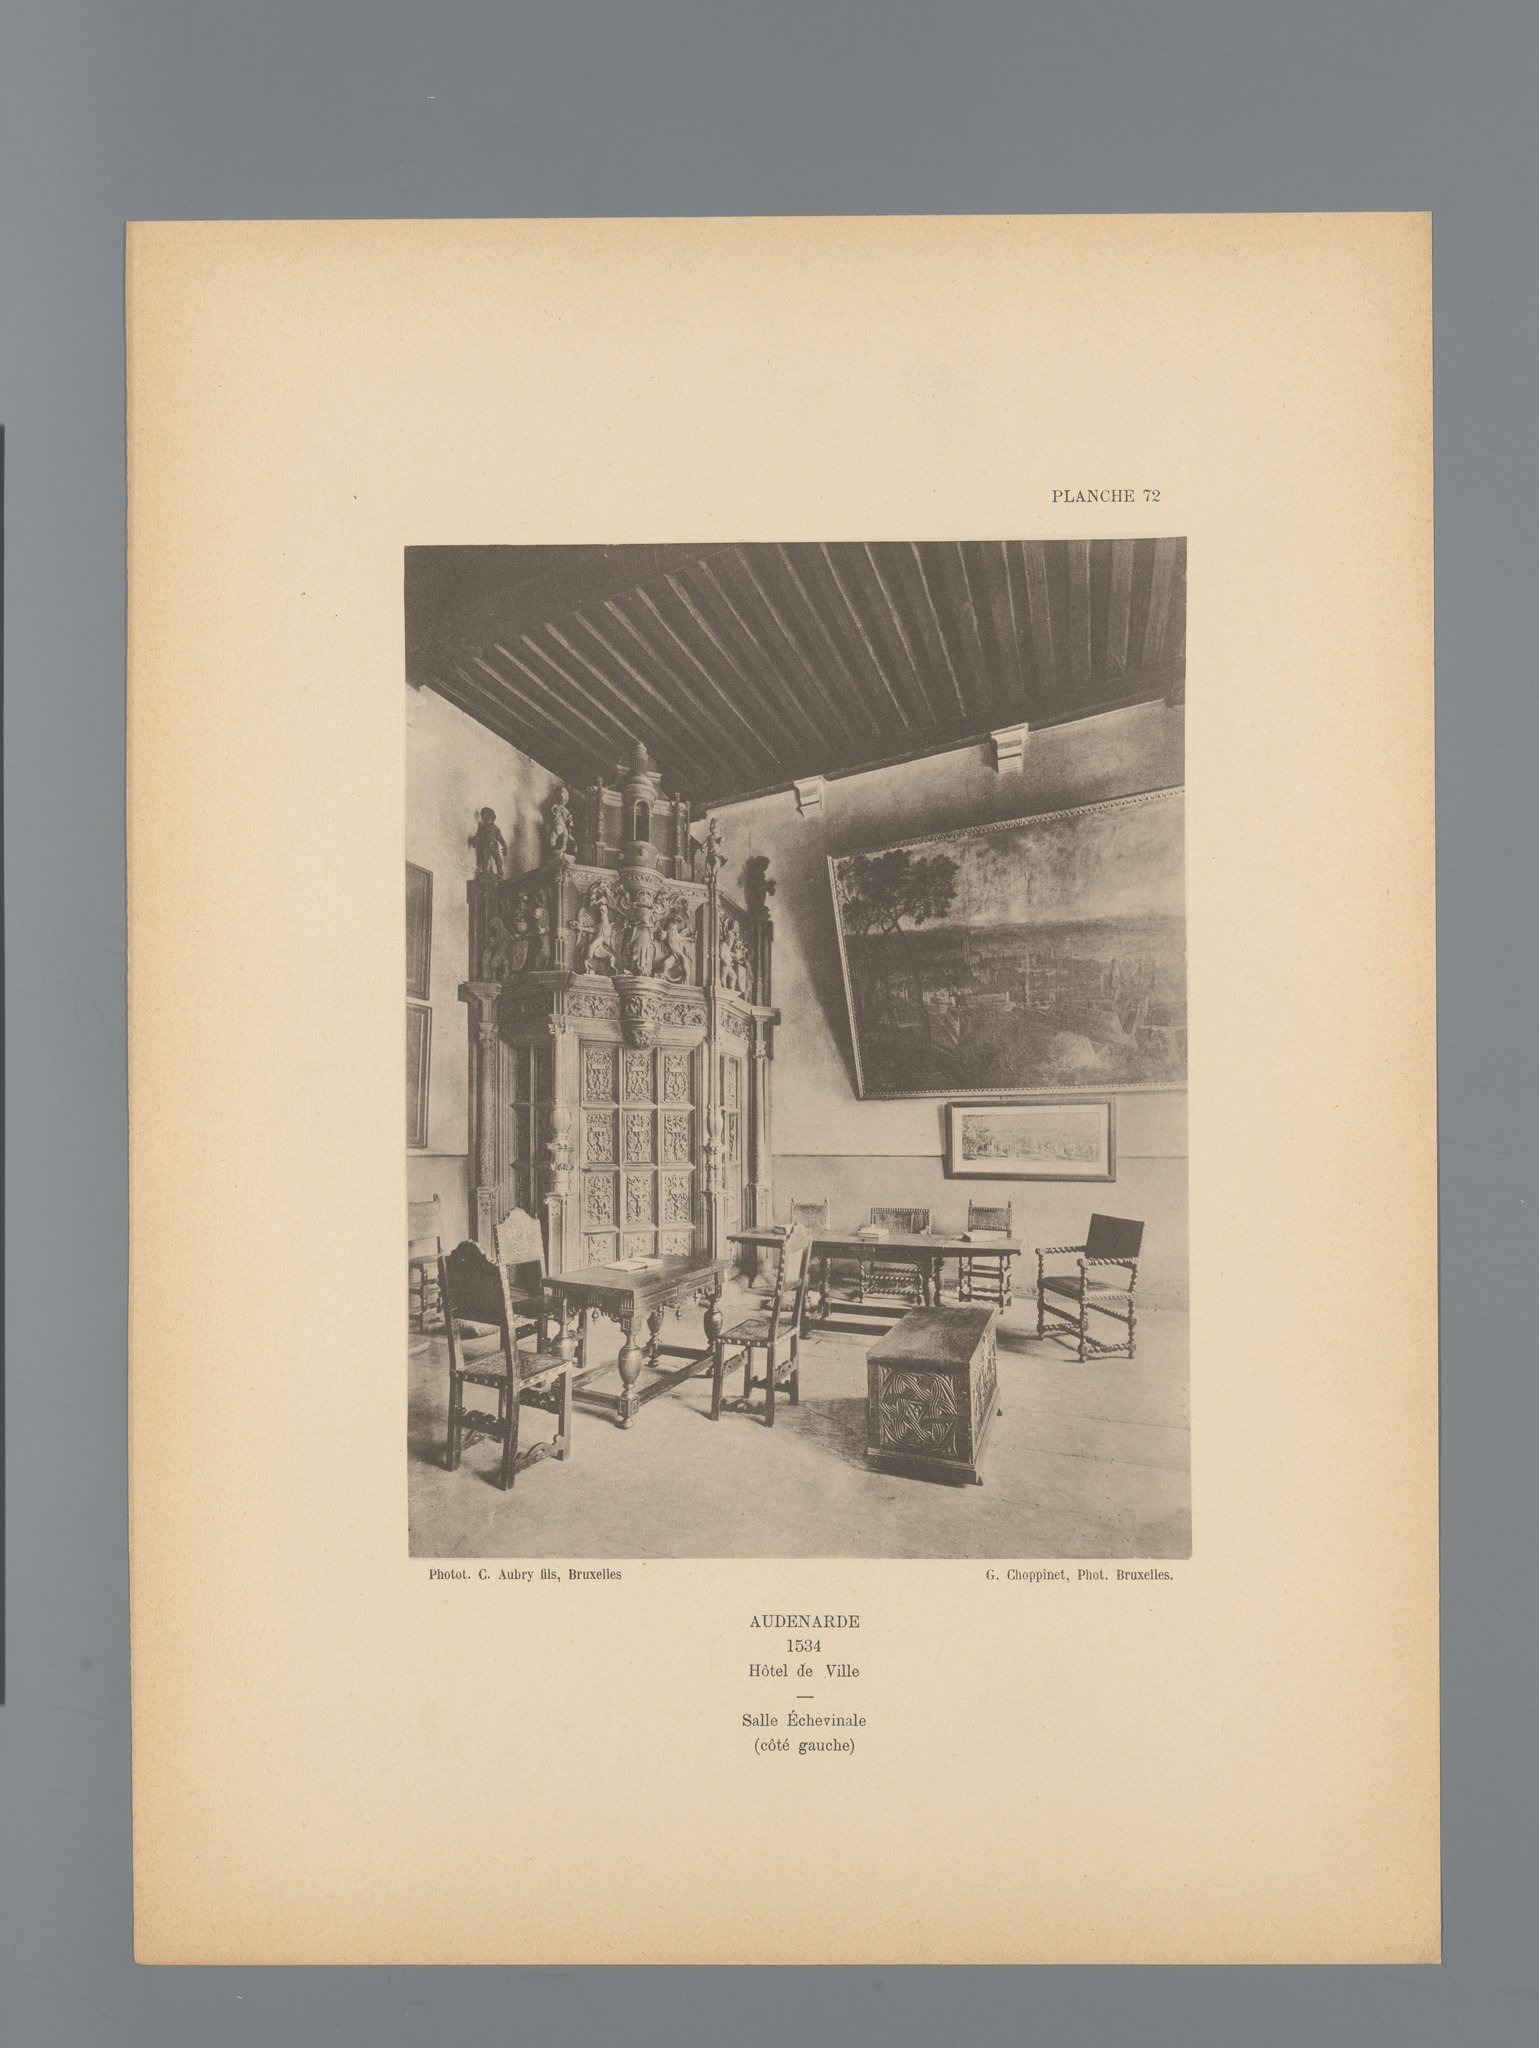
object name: photomechanical print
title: Audenarde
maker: gustave choppinet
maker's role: fotograaf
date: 1893-1898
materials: paper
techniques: photograph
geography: brussels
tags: townhall, interior of the house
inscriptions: inscription: ‘1534/ Hôtel de Ville/ Salle Échevinale/ (côté gauche)’, number: ‘PLANCHE 72’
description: Deze prent maakt deel uit van een omslag met 89 prenten en 5 tekstbladen.